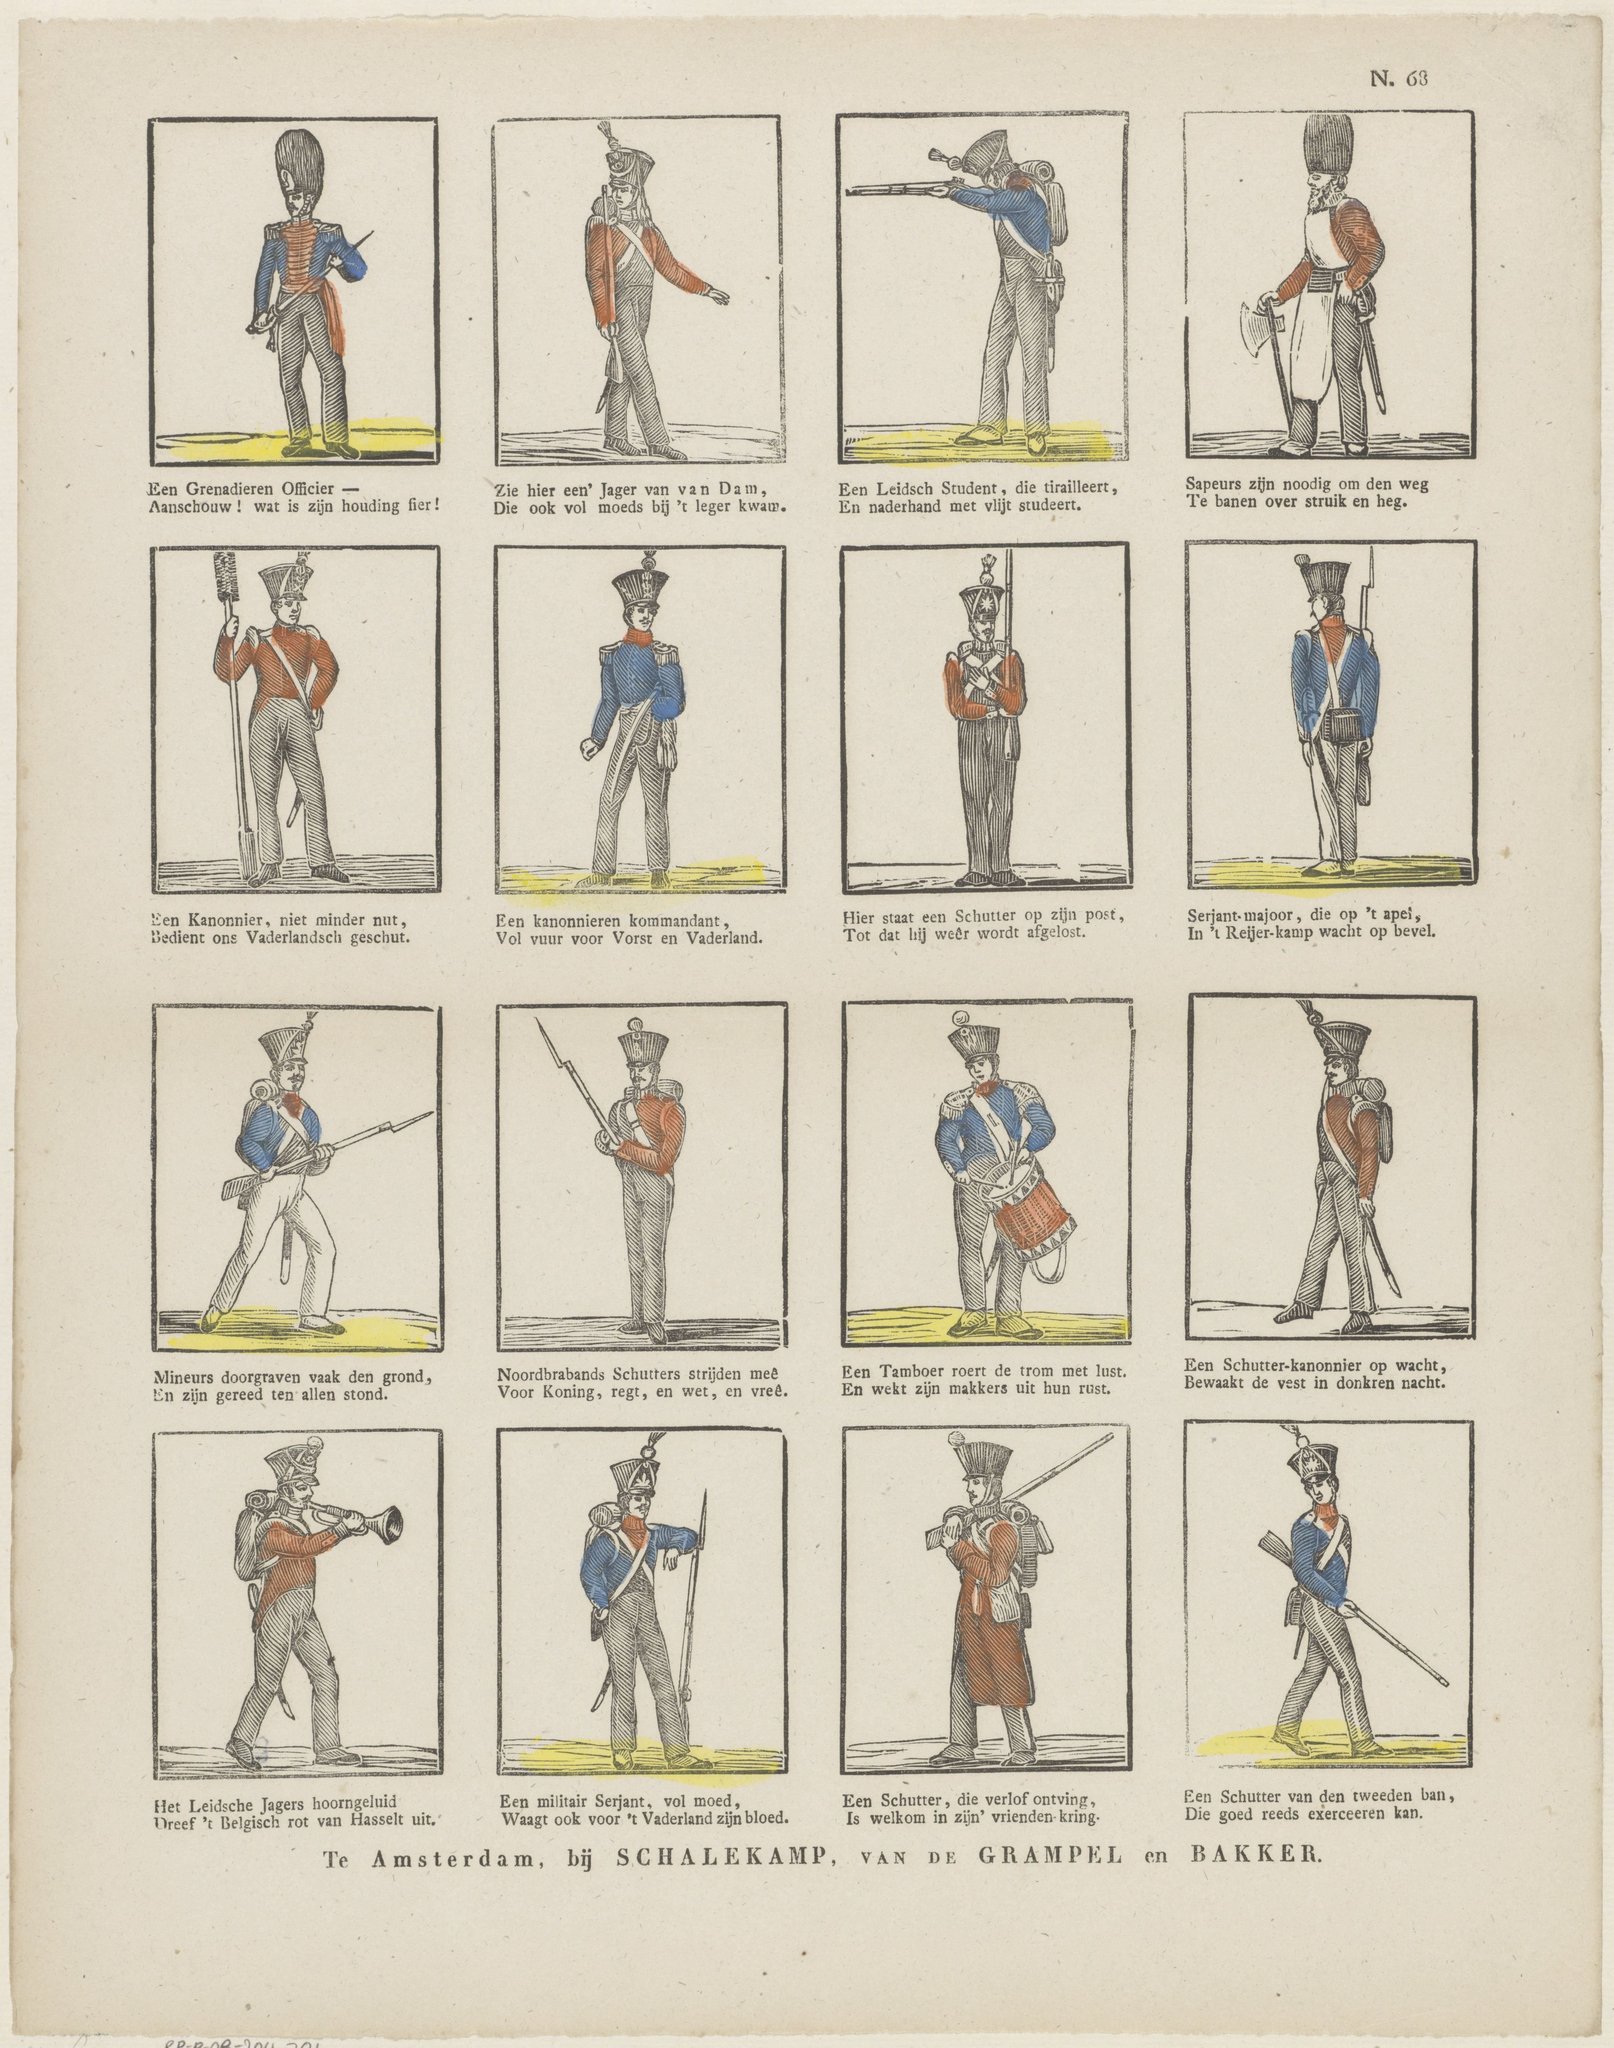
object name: popular print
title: Militairen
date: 1822-1849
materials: paper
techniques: colour, letterpress printing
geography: netherlands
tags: the soldier; the soldier's life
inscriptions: collector's mark: Lugt 2760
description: Uitgave van nr. 68 uit de fondslijst van Jan de Lange (II) met het adres van de wederverkoper Schalekamp, Van de Grampel & Bakker.